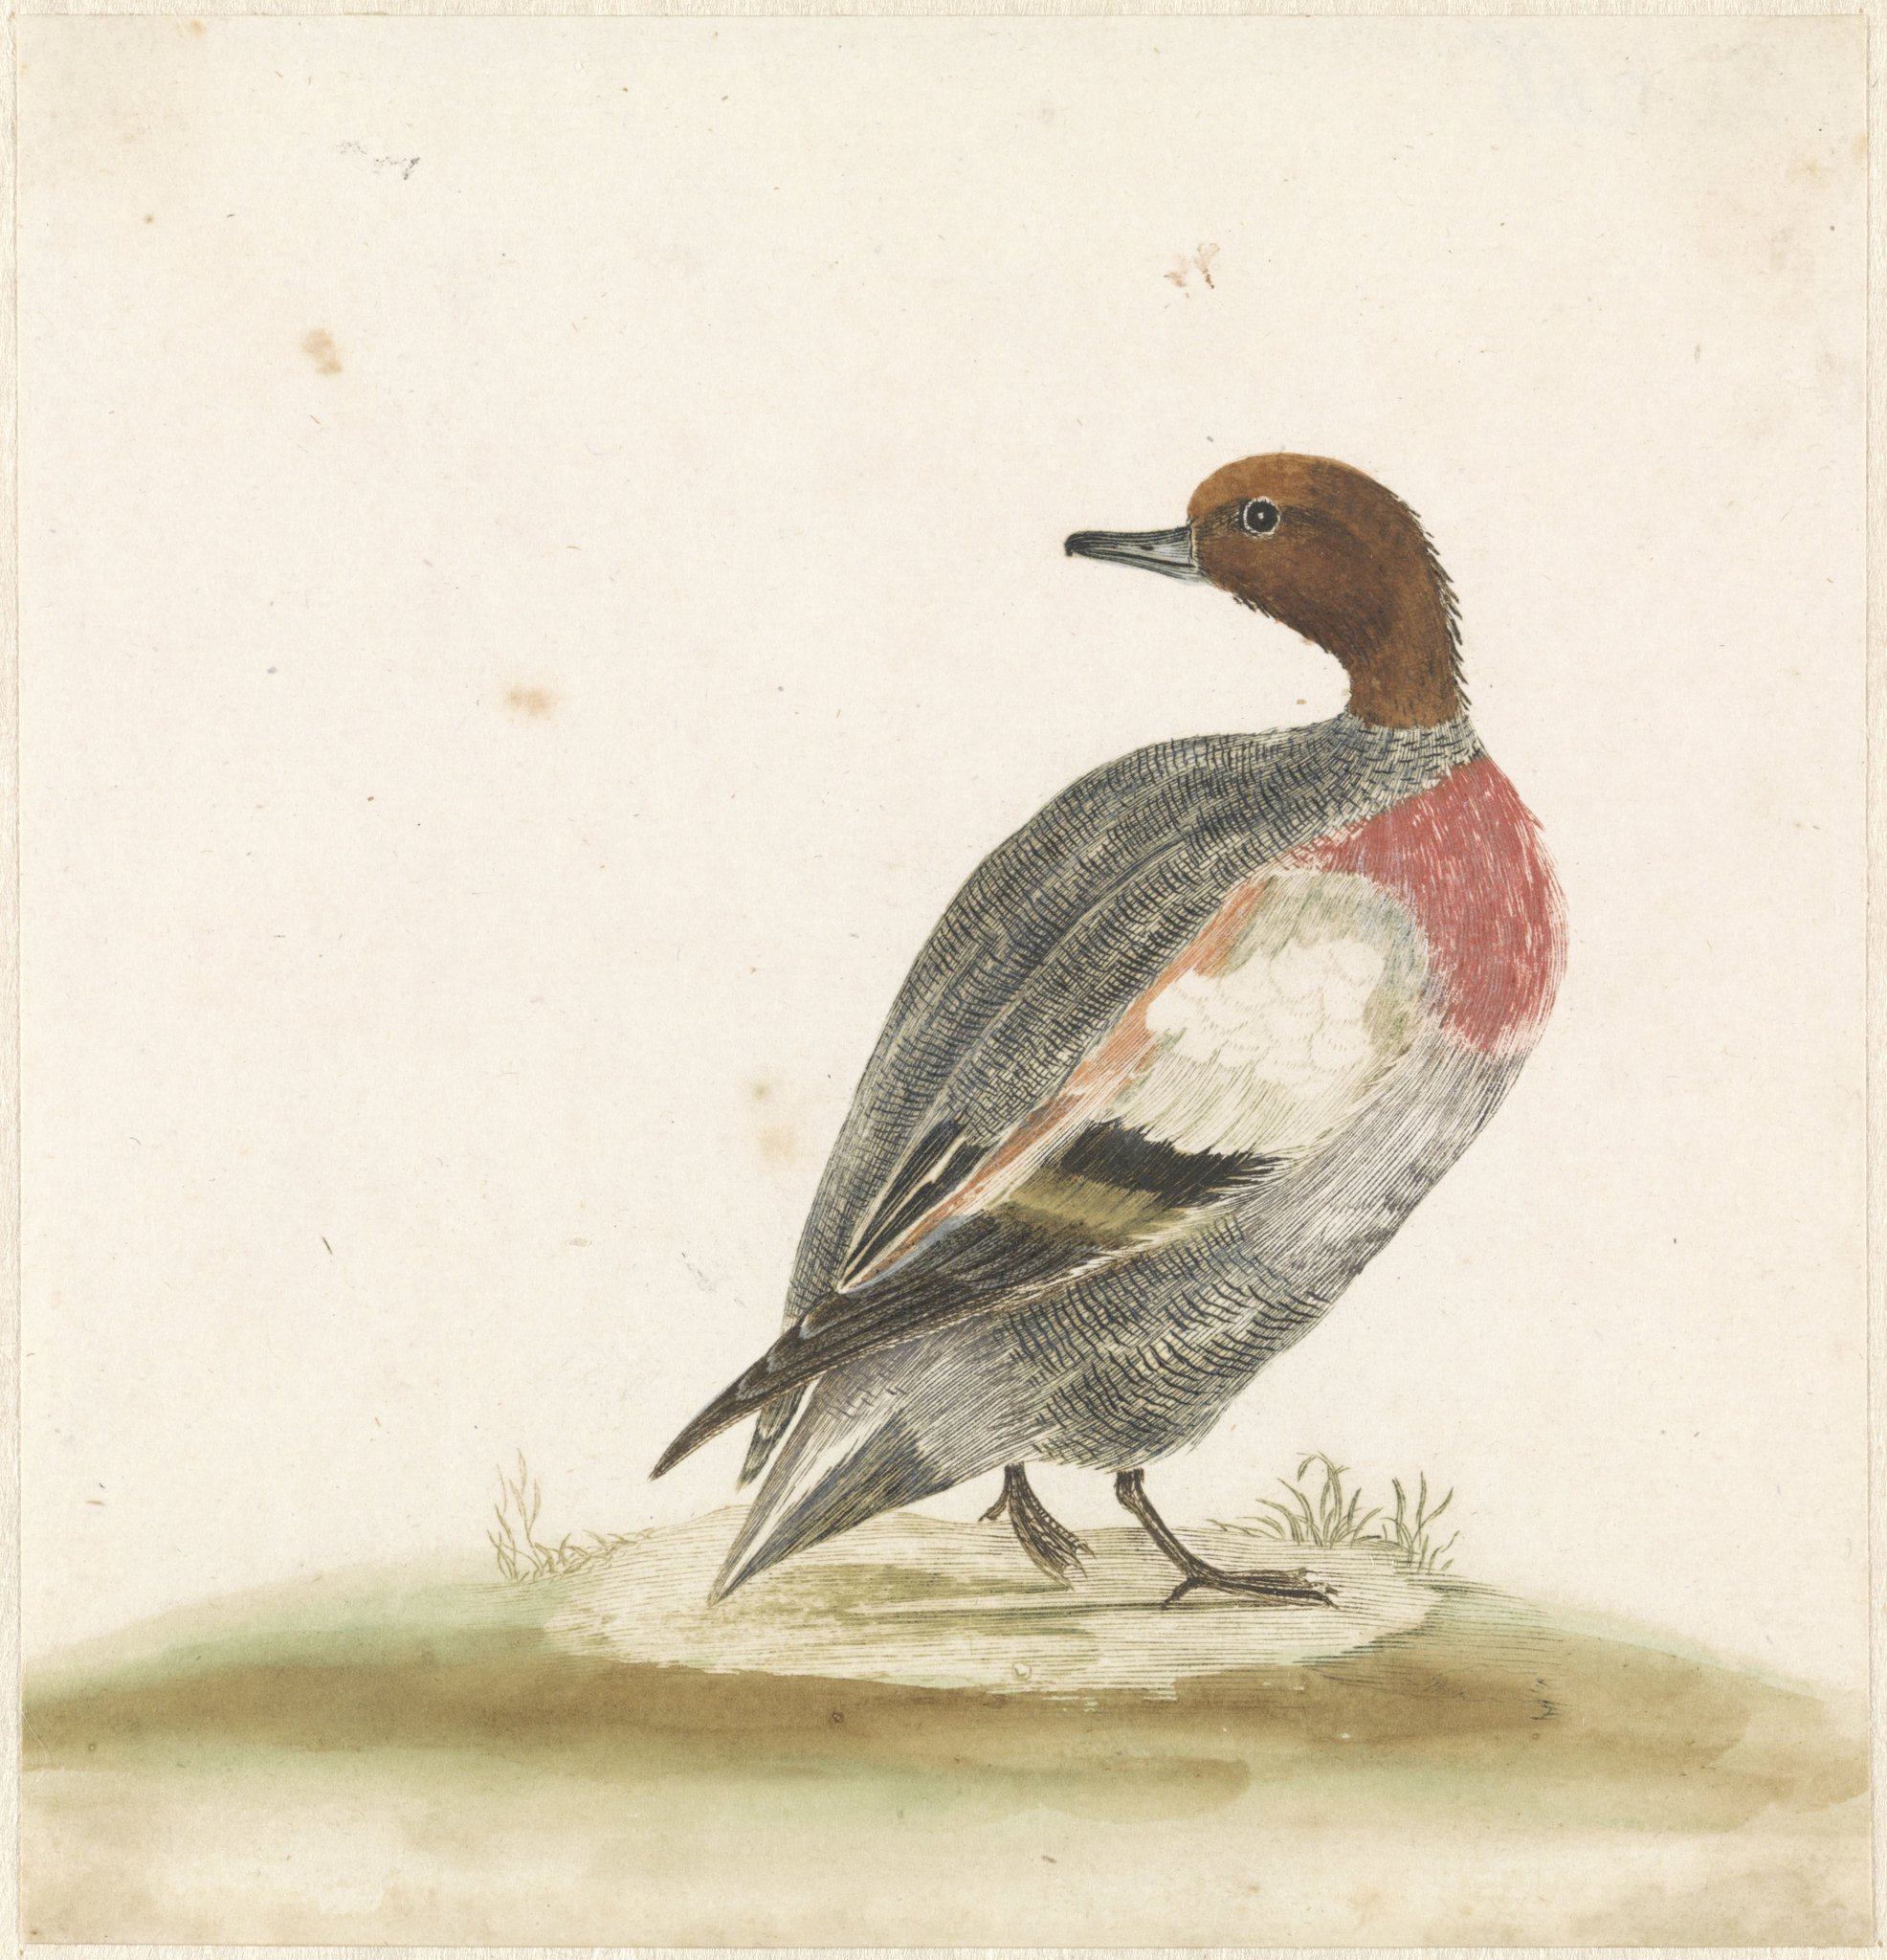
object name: print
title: Eend naar rechts, kijkend naar links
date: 1688-1698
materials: paper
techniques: printing, engraving, hand coloring, lithography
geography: netherlands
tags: water-birds: duck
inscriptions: collector's mark: Lugt 2228